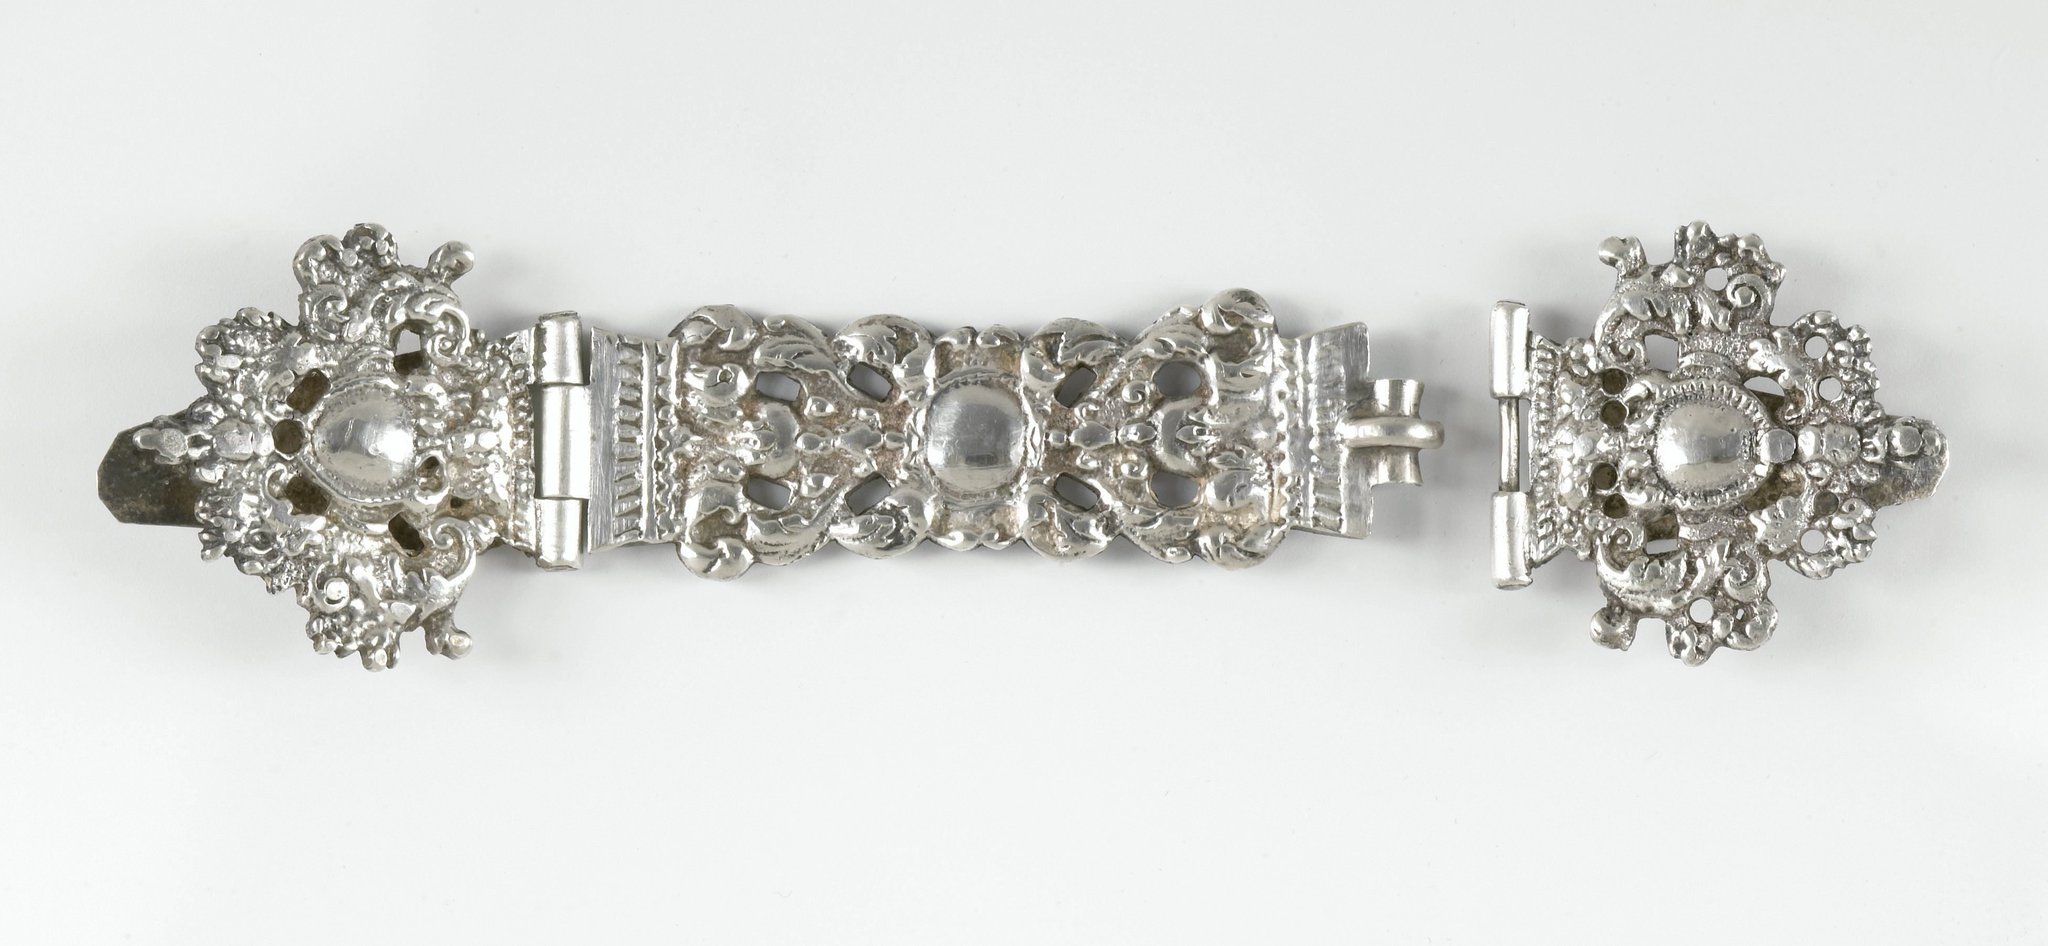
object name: boekslot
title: Boekslot, versierd met medaillons en acanthusblad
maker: lykele stevens hoornstra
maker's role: silversmith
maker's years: 1706-1767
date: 1754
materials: silver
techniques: casting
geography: heerenveen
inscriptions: date: ‘1754’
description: Boekslot van zilver, bestaande uit klamp en aanhechtstuk, versierd met medaillons en acanthusblad. Op de achterzijde het jaartal 1754.